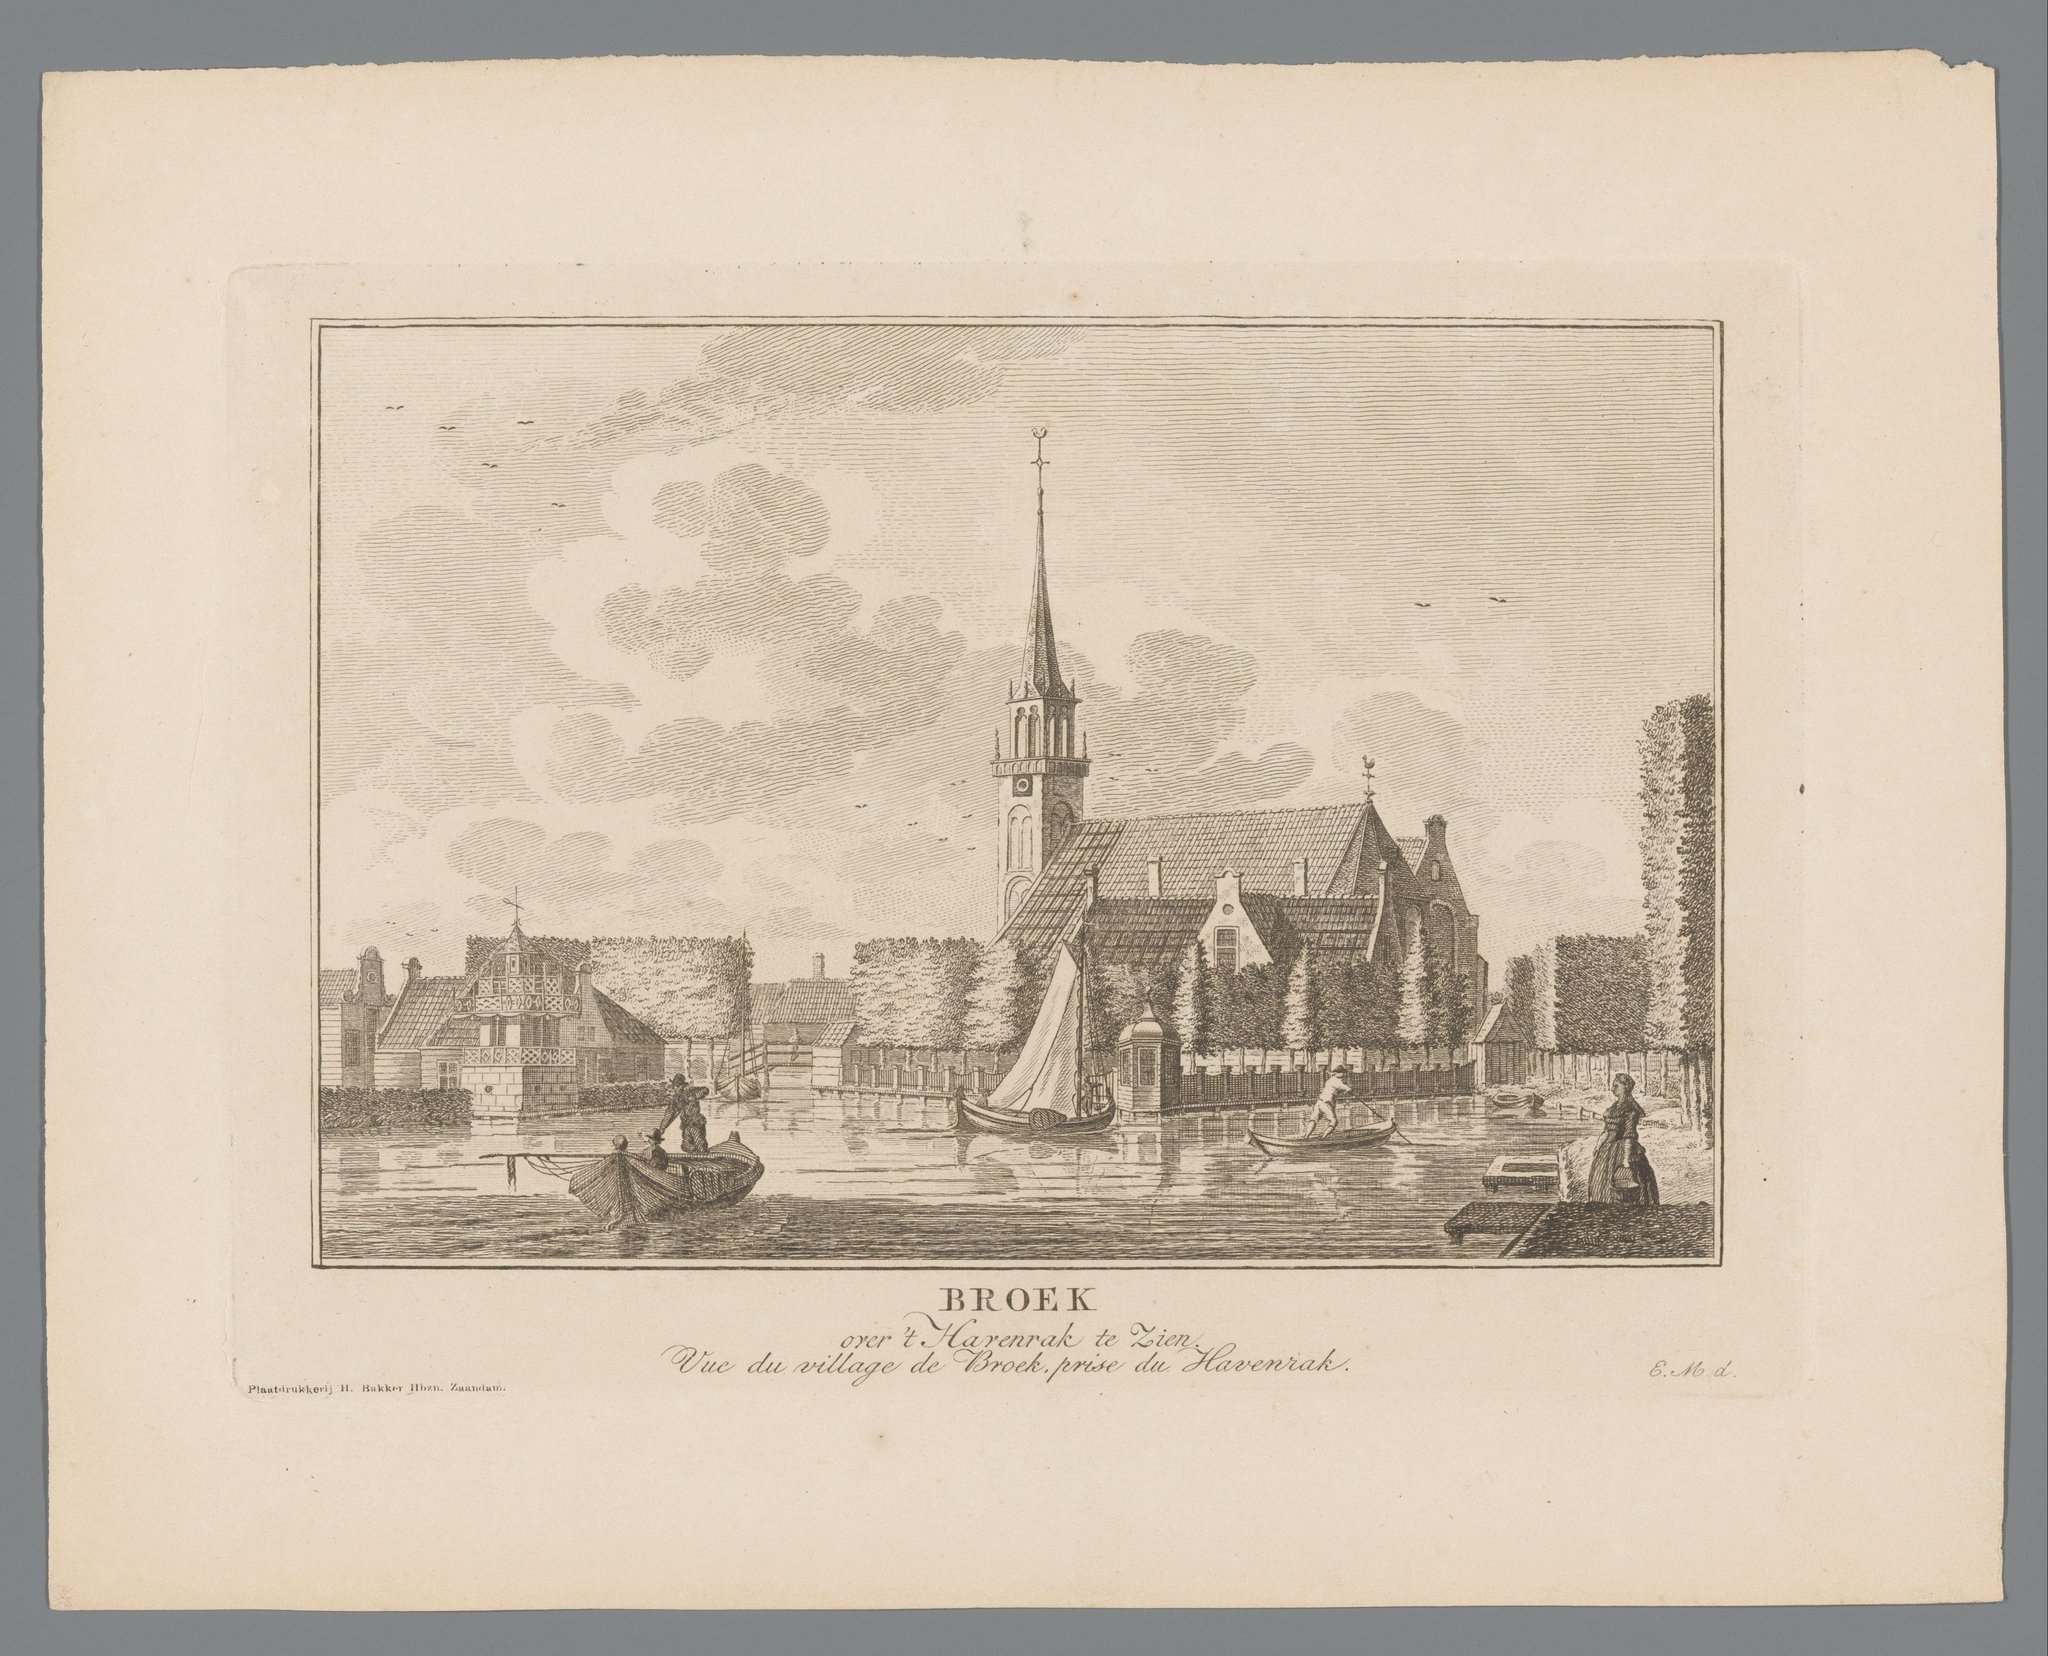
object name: print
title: Broek, over 't Havenrak te zien / Vue de village de Broek. prise du Havenrak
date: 1786-1792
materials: paper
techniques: etching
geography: amsterdam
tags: prospect of city, town panorama, silhouette of city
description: Huidige staat van prent uitgegeven als onderdeel van een plaatwerk uit ca. 1824-1825 met 74 (ongenummerde) platen van de belangrijkste topografische gezichten en verschillende zeden en gewoonten in het Verenigd Koninkrijk der Nederlanden, getiteld 'Tableau des principales vues des palais et édifices : représentations et des coutumes et usages, dans les provinces septentrionales du Royaume des Pays-Bas'. Eerdere staat gebruikt in: Vaderlandsche gezichten, of afbeeldingen van den tegenwoordigen staat der Vereenigde Nederlanden (…). Amsterdam: Hendrik Gartman, Willem Vermandel en Jan Willem Smit, 1786-1792. Uitgegeven in afleveringen met ieder een eigen bifolium en inhoudsopgave. Alle prenten in deze publicatie zijn gegraveerd door Carel Frederik Bendorp (I) en, in de meeste gevallen, gebaseerd op tekeningen van Jan Bulthuis.